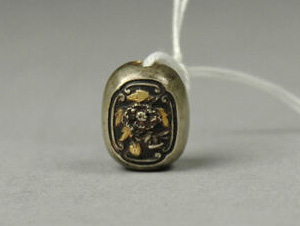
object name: ojime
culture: japanese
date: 1801-1900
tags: flowers,leaves